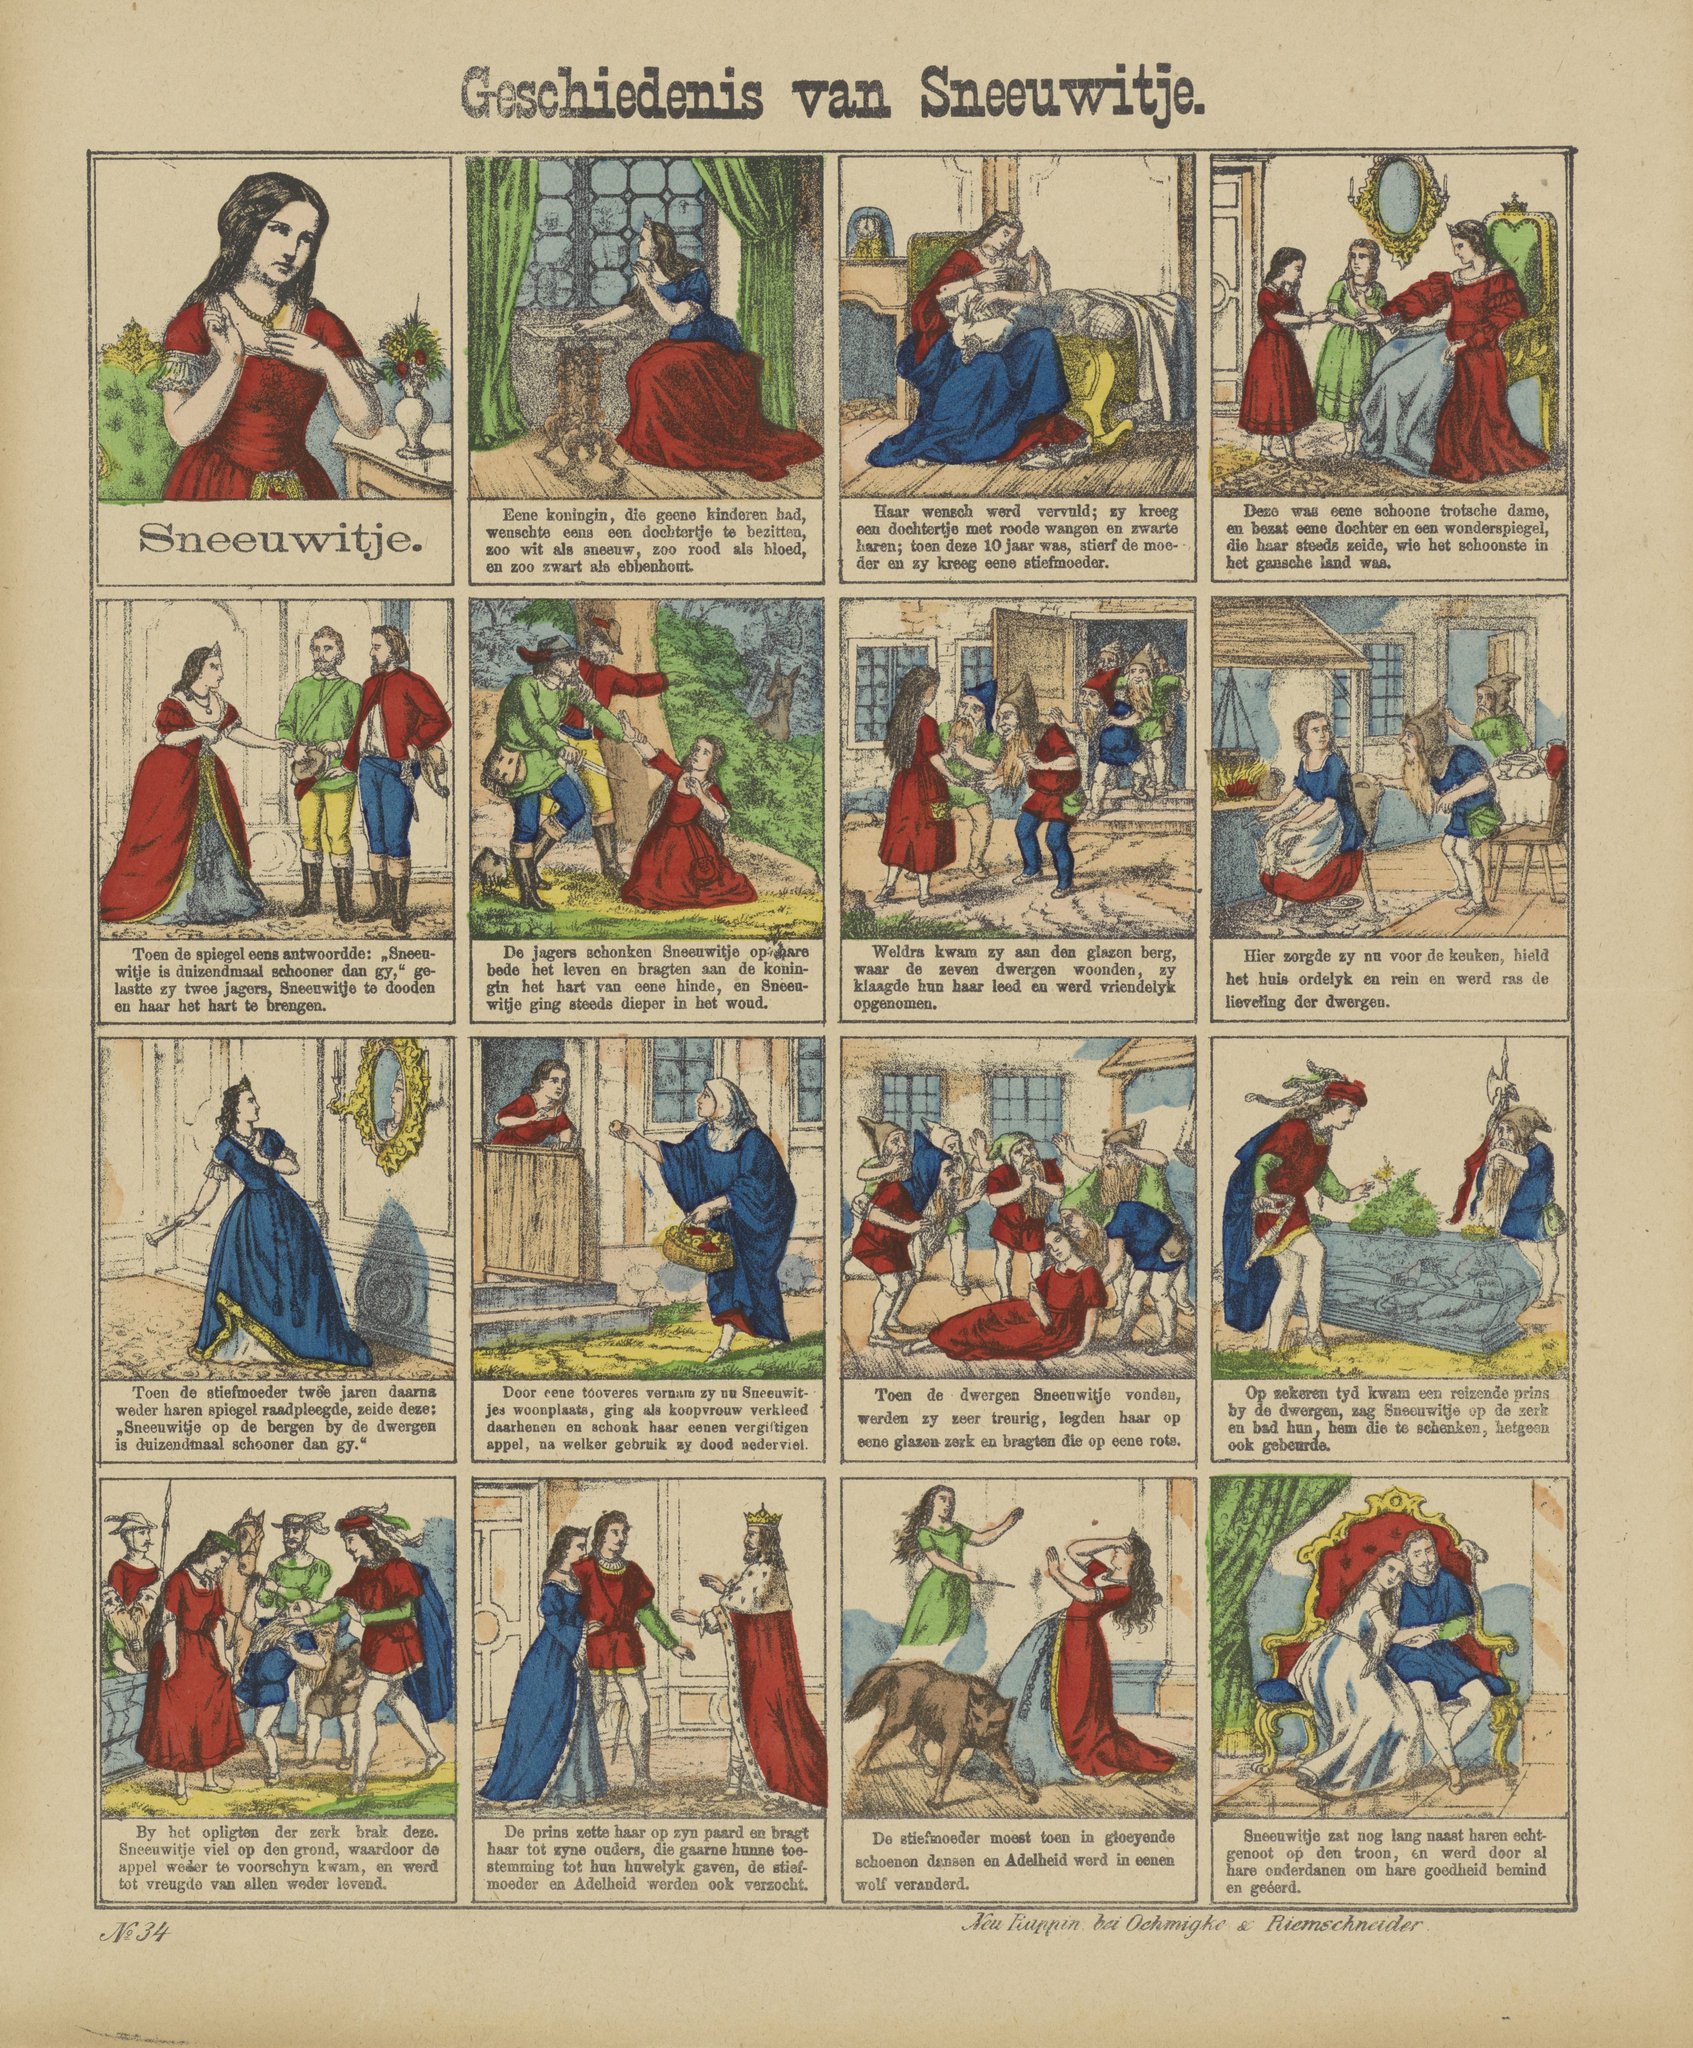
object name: print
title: Geschiedenis van Sneeuwitje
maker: Anonymous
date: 1828-1937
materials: paper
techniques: hand coloring, letterpress printing, lithograph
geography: neuruppin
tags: princess, tales and fairy tales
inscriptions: collector's mark: Lugt 2760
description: Blad met 16 voorstellingen uit het sprookje van Sneeuwwitje. Onder elke afbeelding een onderschrift. Genummerd linksonder: No. 34.